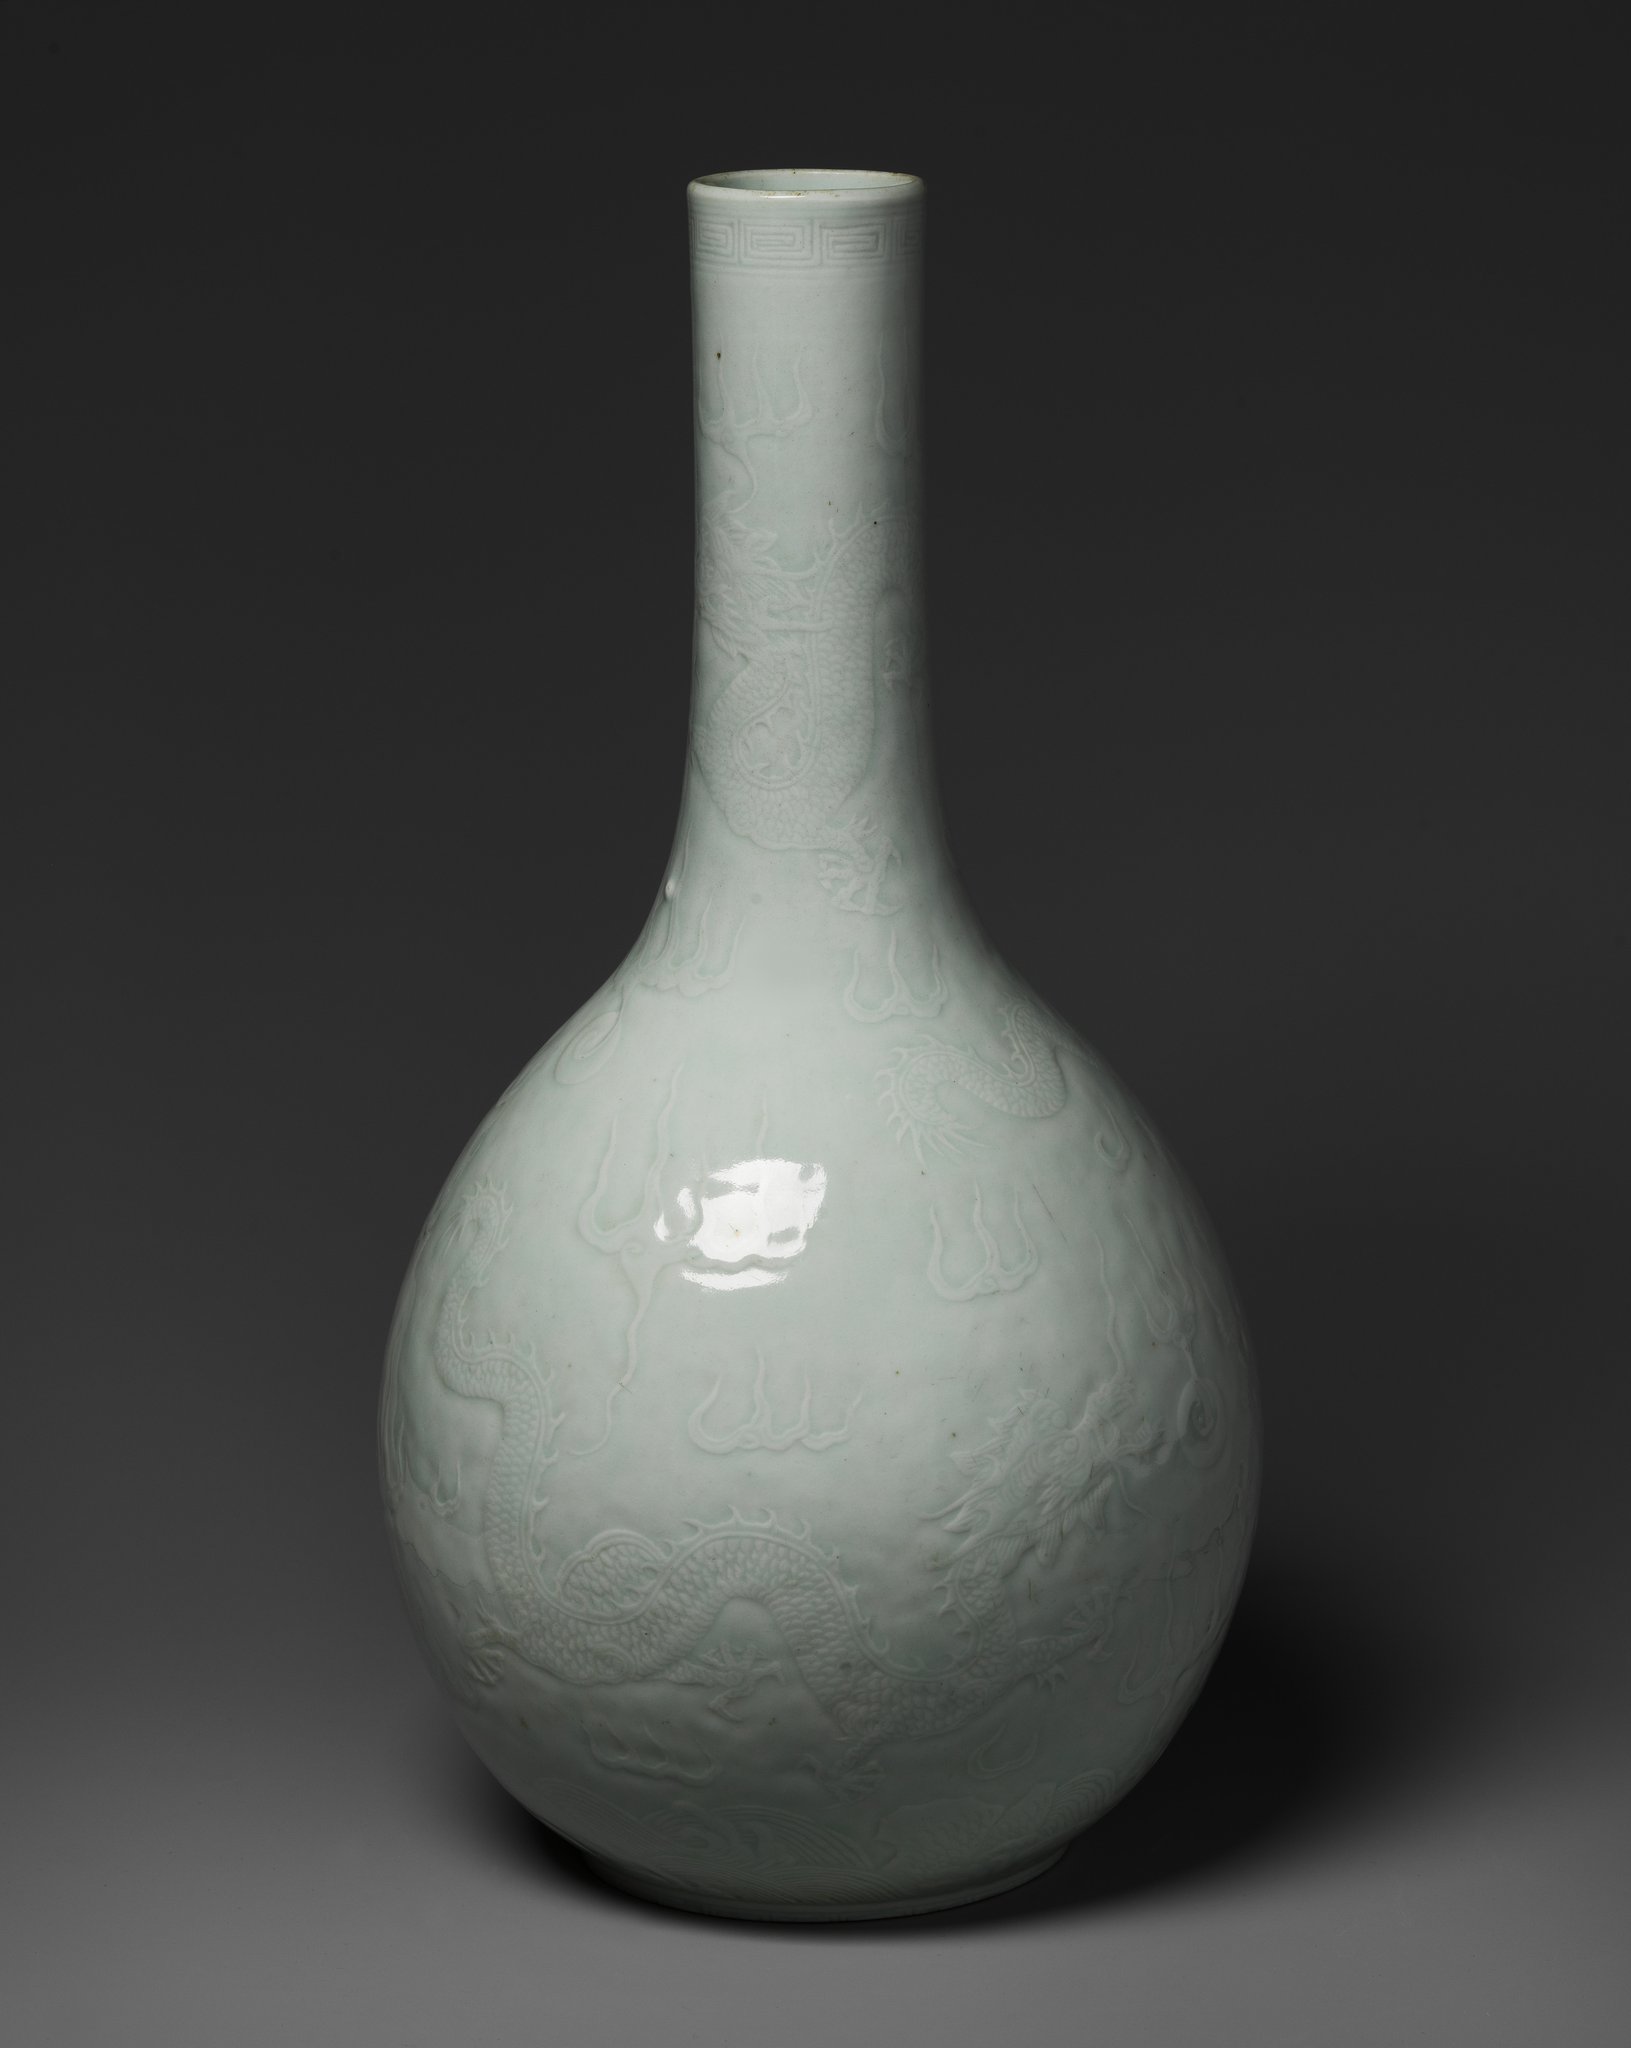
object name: bottle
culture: japanese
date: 1701-1800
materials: porcelain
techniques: incising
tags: dragons